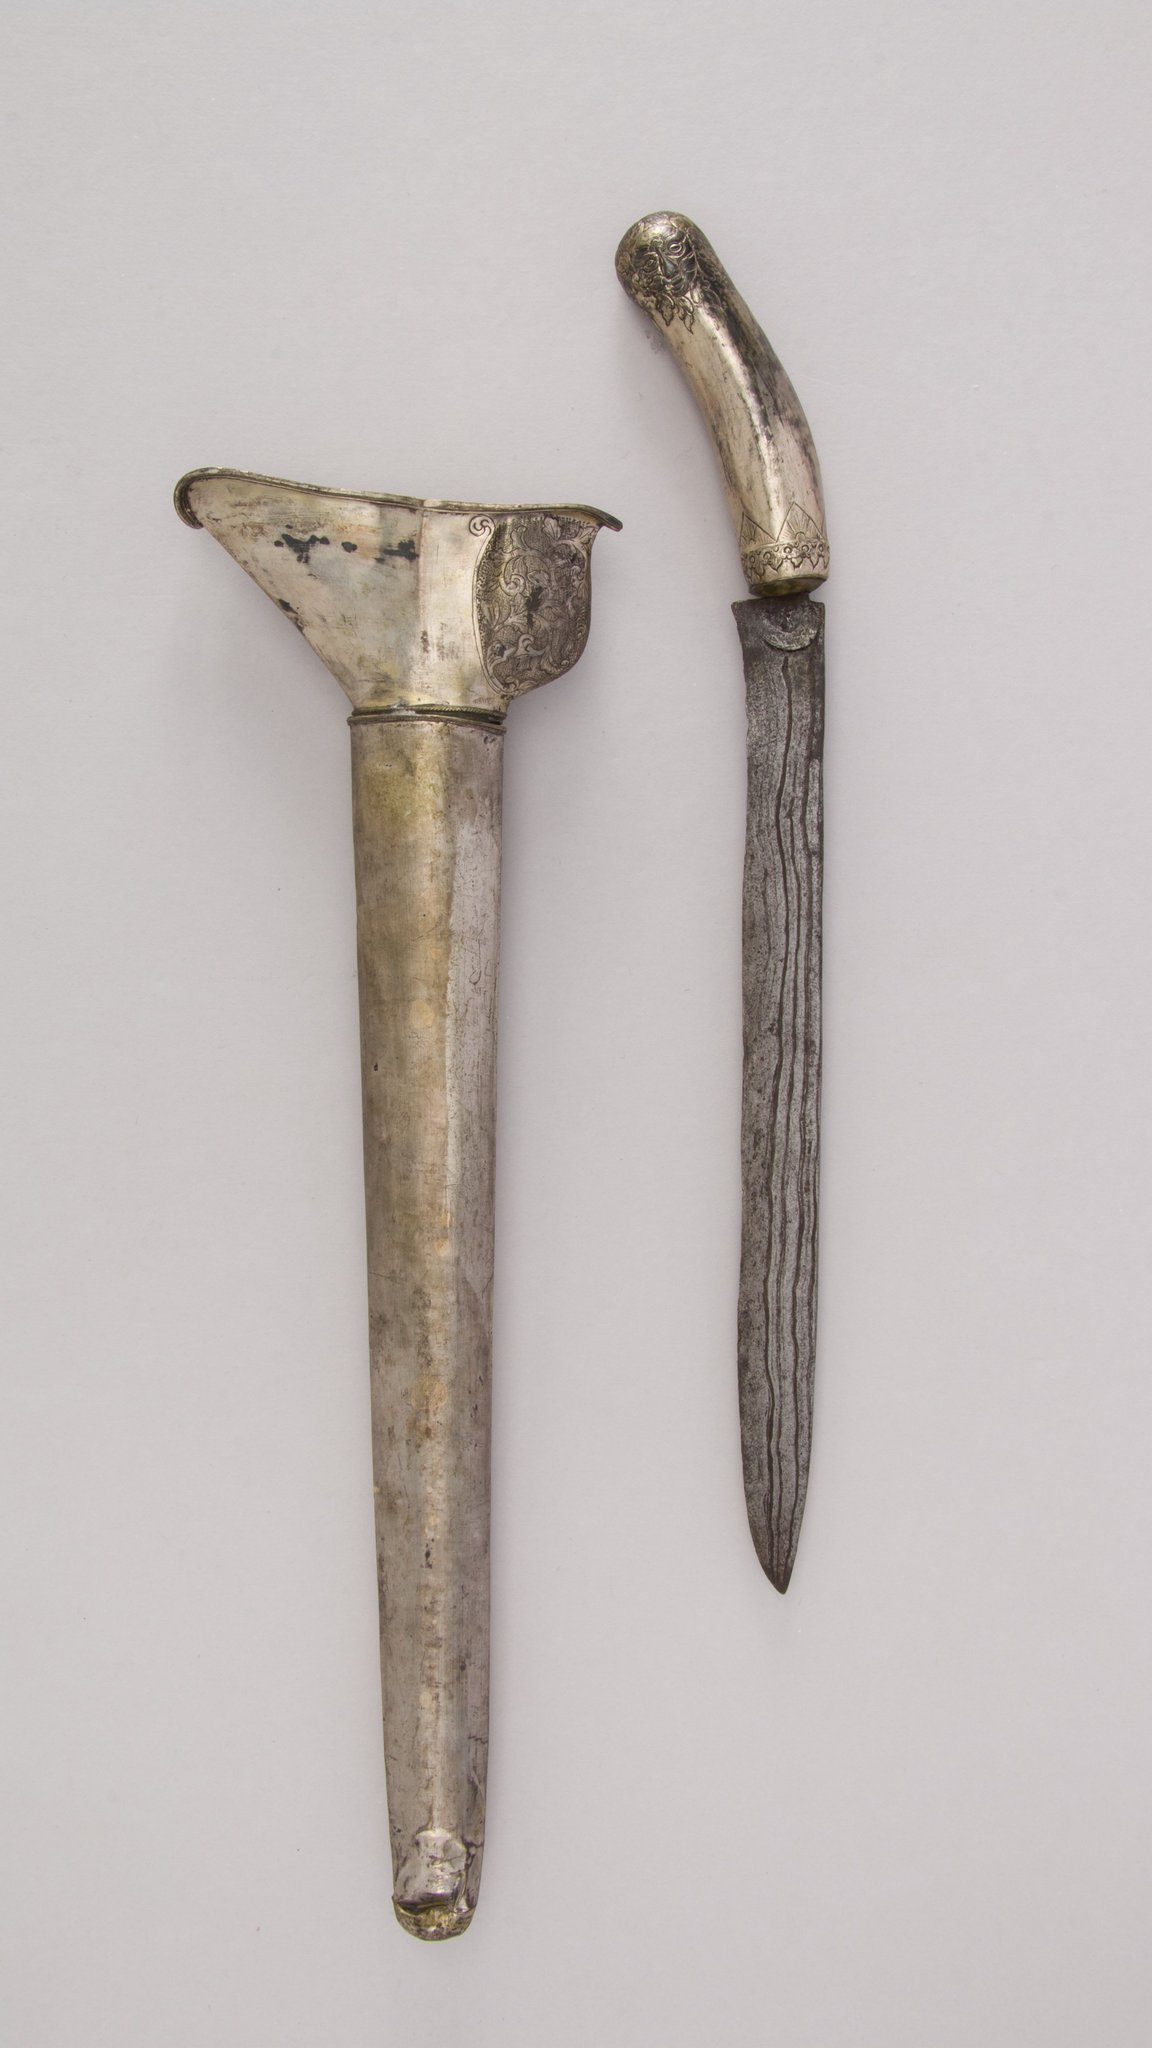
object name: knife with sheath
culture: malayan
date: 1701-1900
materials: silver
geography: malaysia